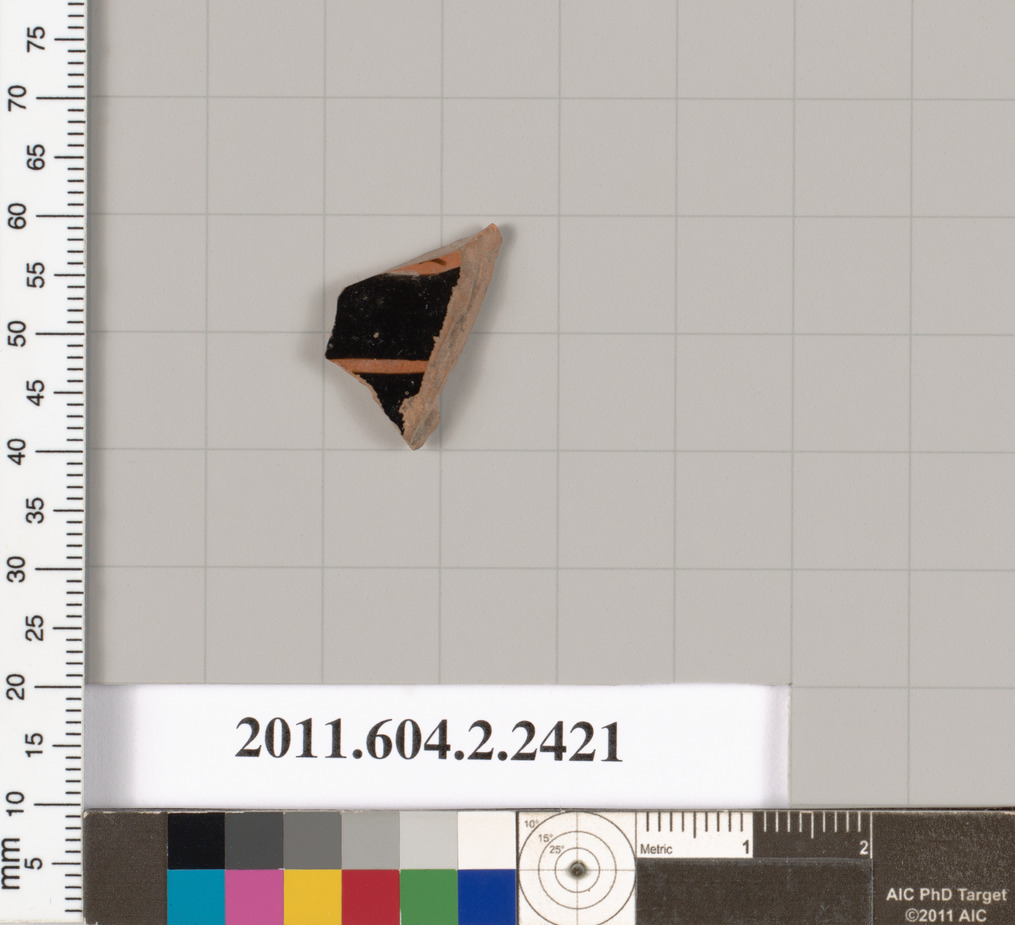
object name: undetermined shape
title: Terracotta fragment of an undetermined shape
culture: greek, attic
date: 600-401 BCE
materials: terracotta